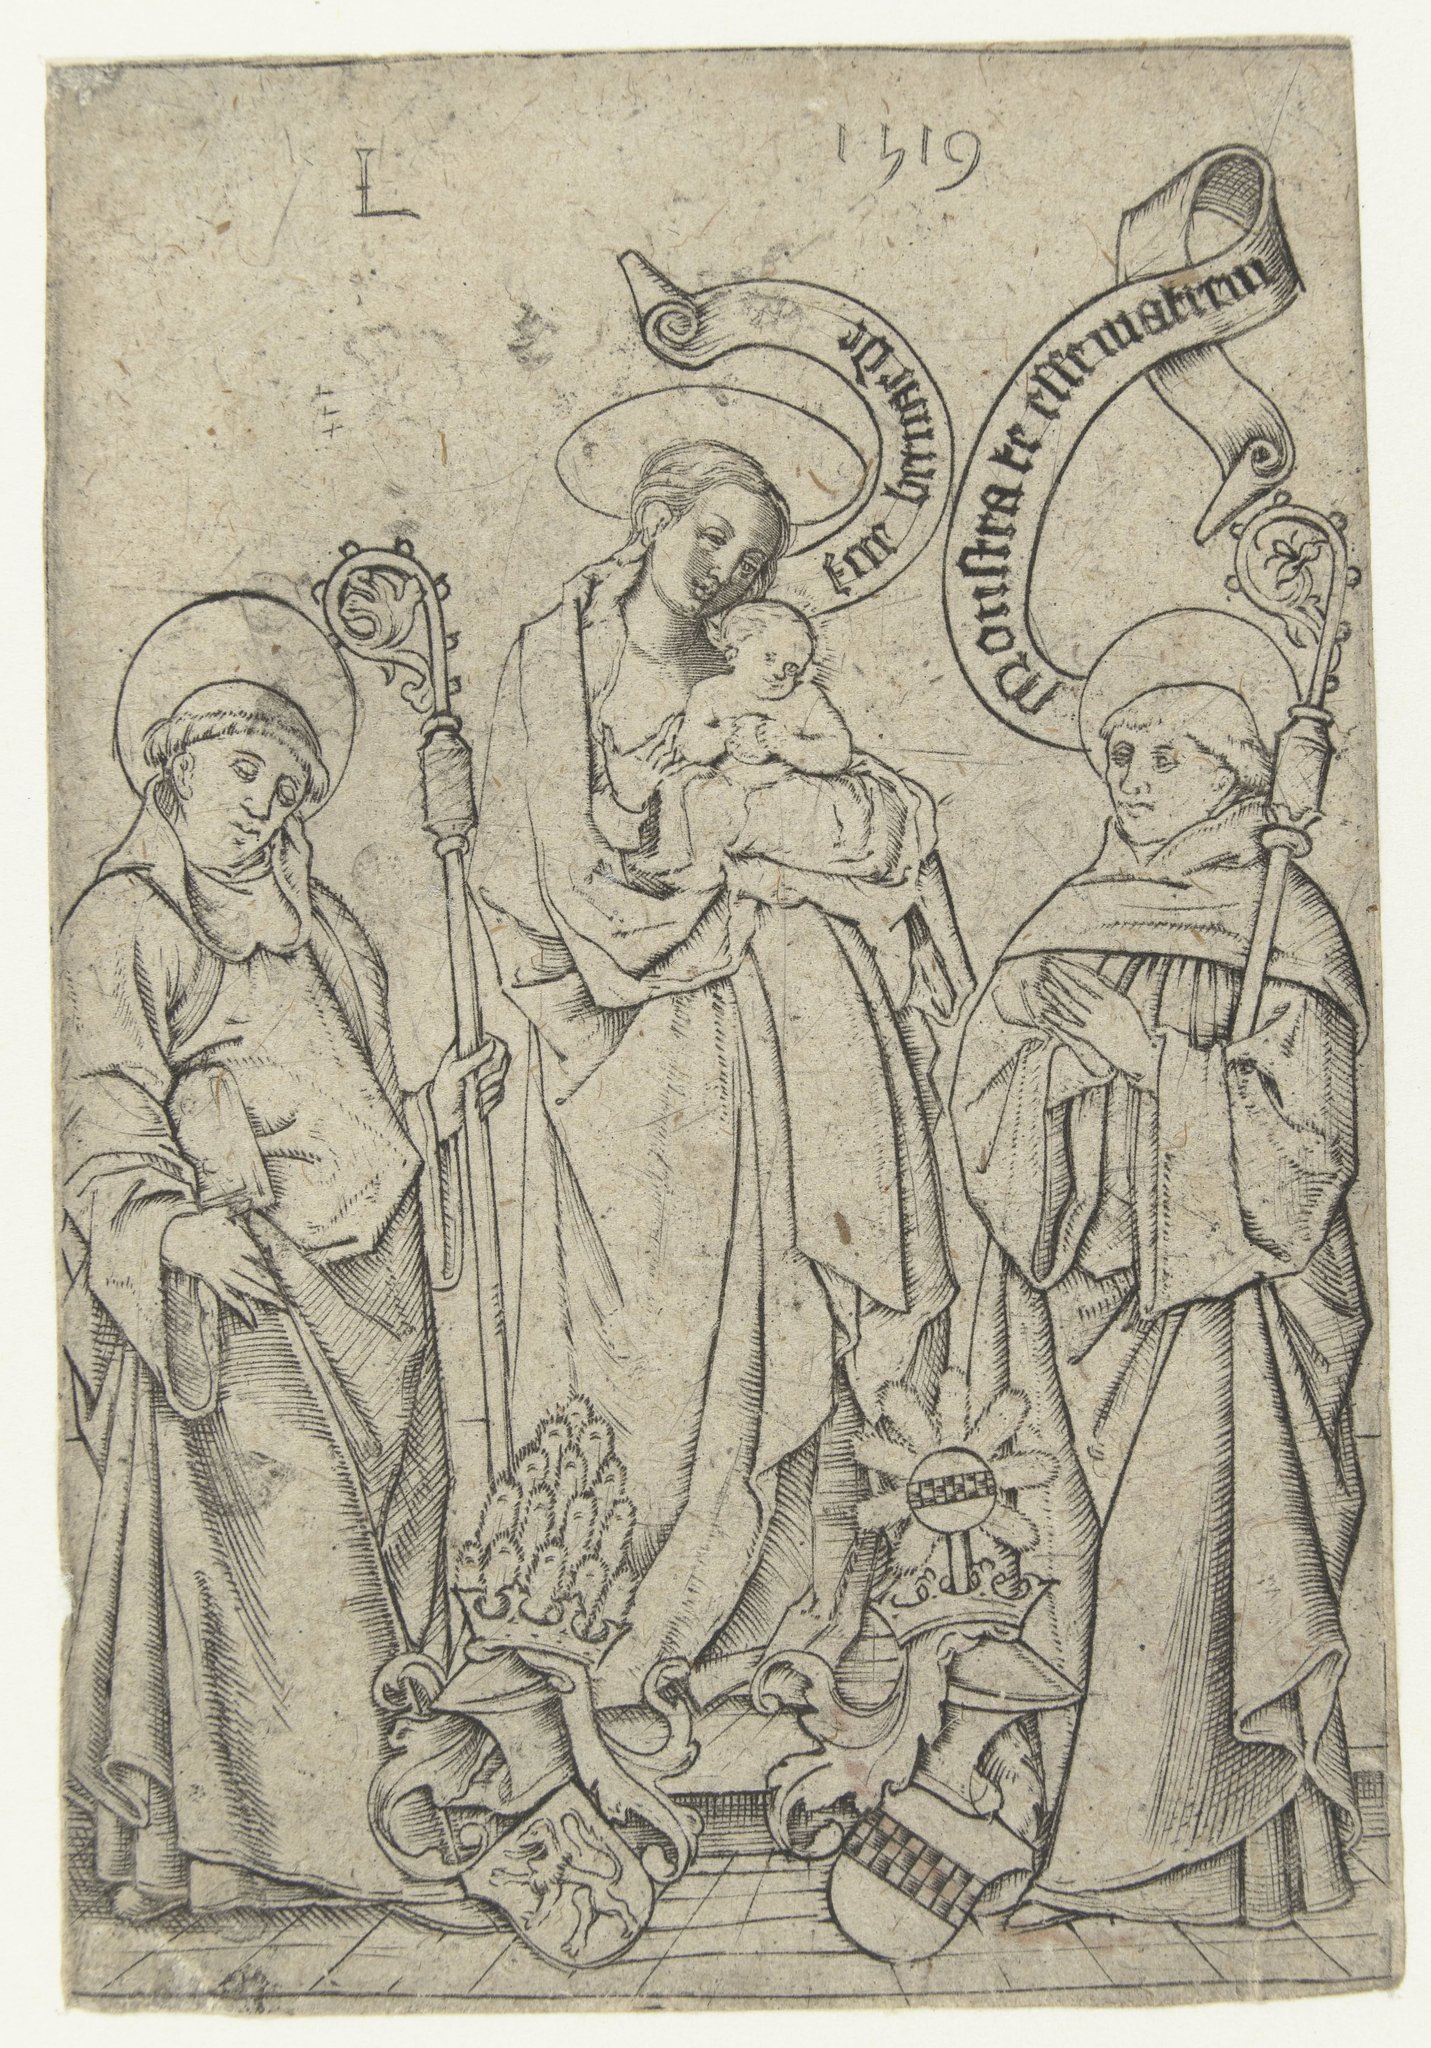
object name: print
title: Maria met kind en twee heiligen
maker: monogrammist l (graveur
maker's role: print maker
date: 1519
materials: paper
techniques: engraving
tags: madonna accompanied by saint(s), bernard of clairvaux, cistercian monk and abbot; possible attributes: beehive, chained dragon, crucifix, cross with instruments of the passion, (three) mitre at his feet, white dog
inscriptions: collector's mark: Lugt 240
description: Maria met kind, rechts en links van haar heilige monnik met bisschopsstaf, een van de twee is de heilige Bernardus. Banderol bij het hoofd Maria met tekst "Ecce bernarde", en bij hoofd monnik de tekst "Mostrate esse matrem". Aan de voeten van heiligen liggen wapenschild en helm met versiering.